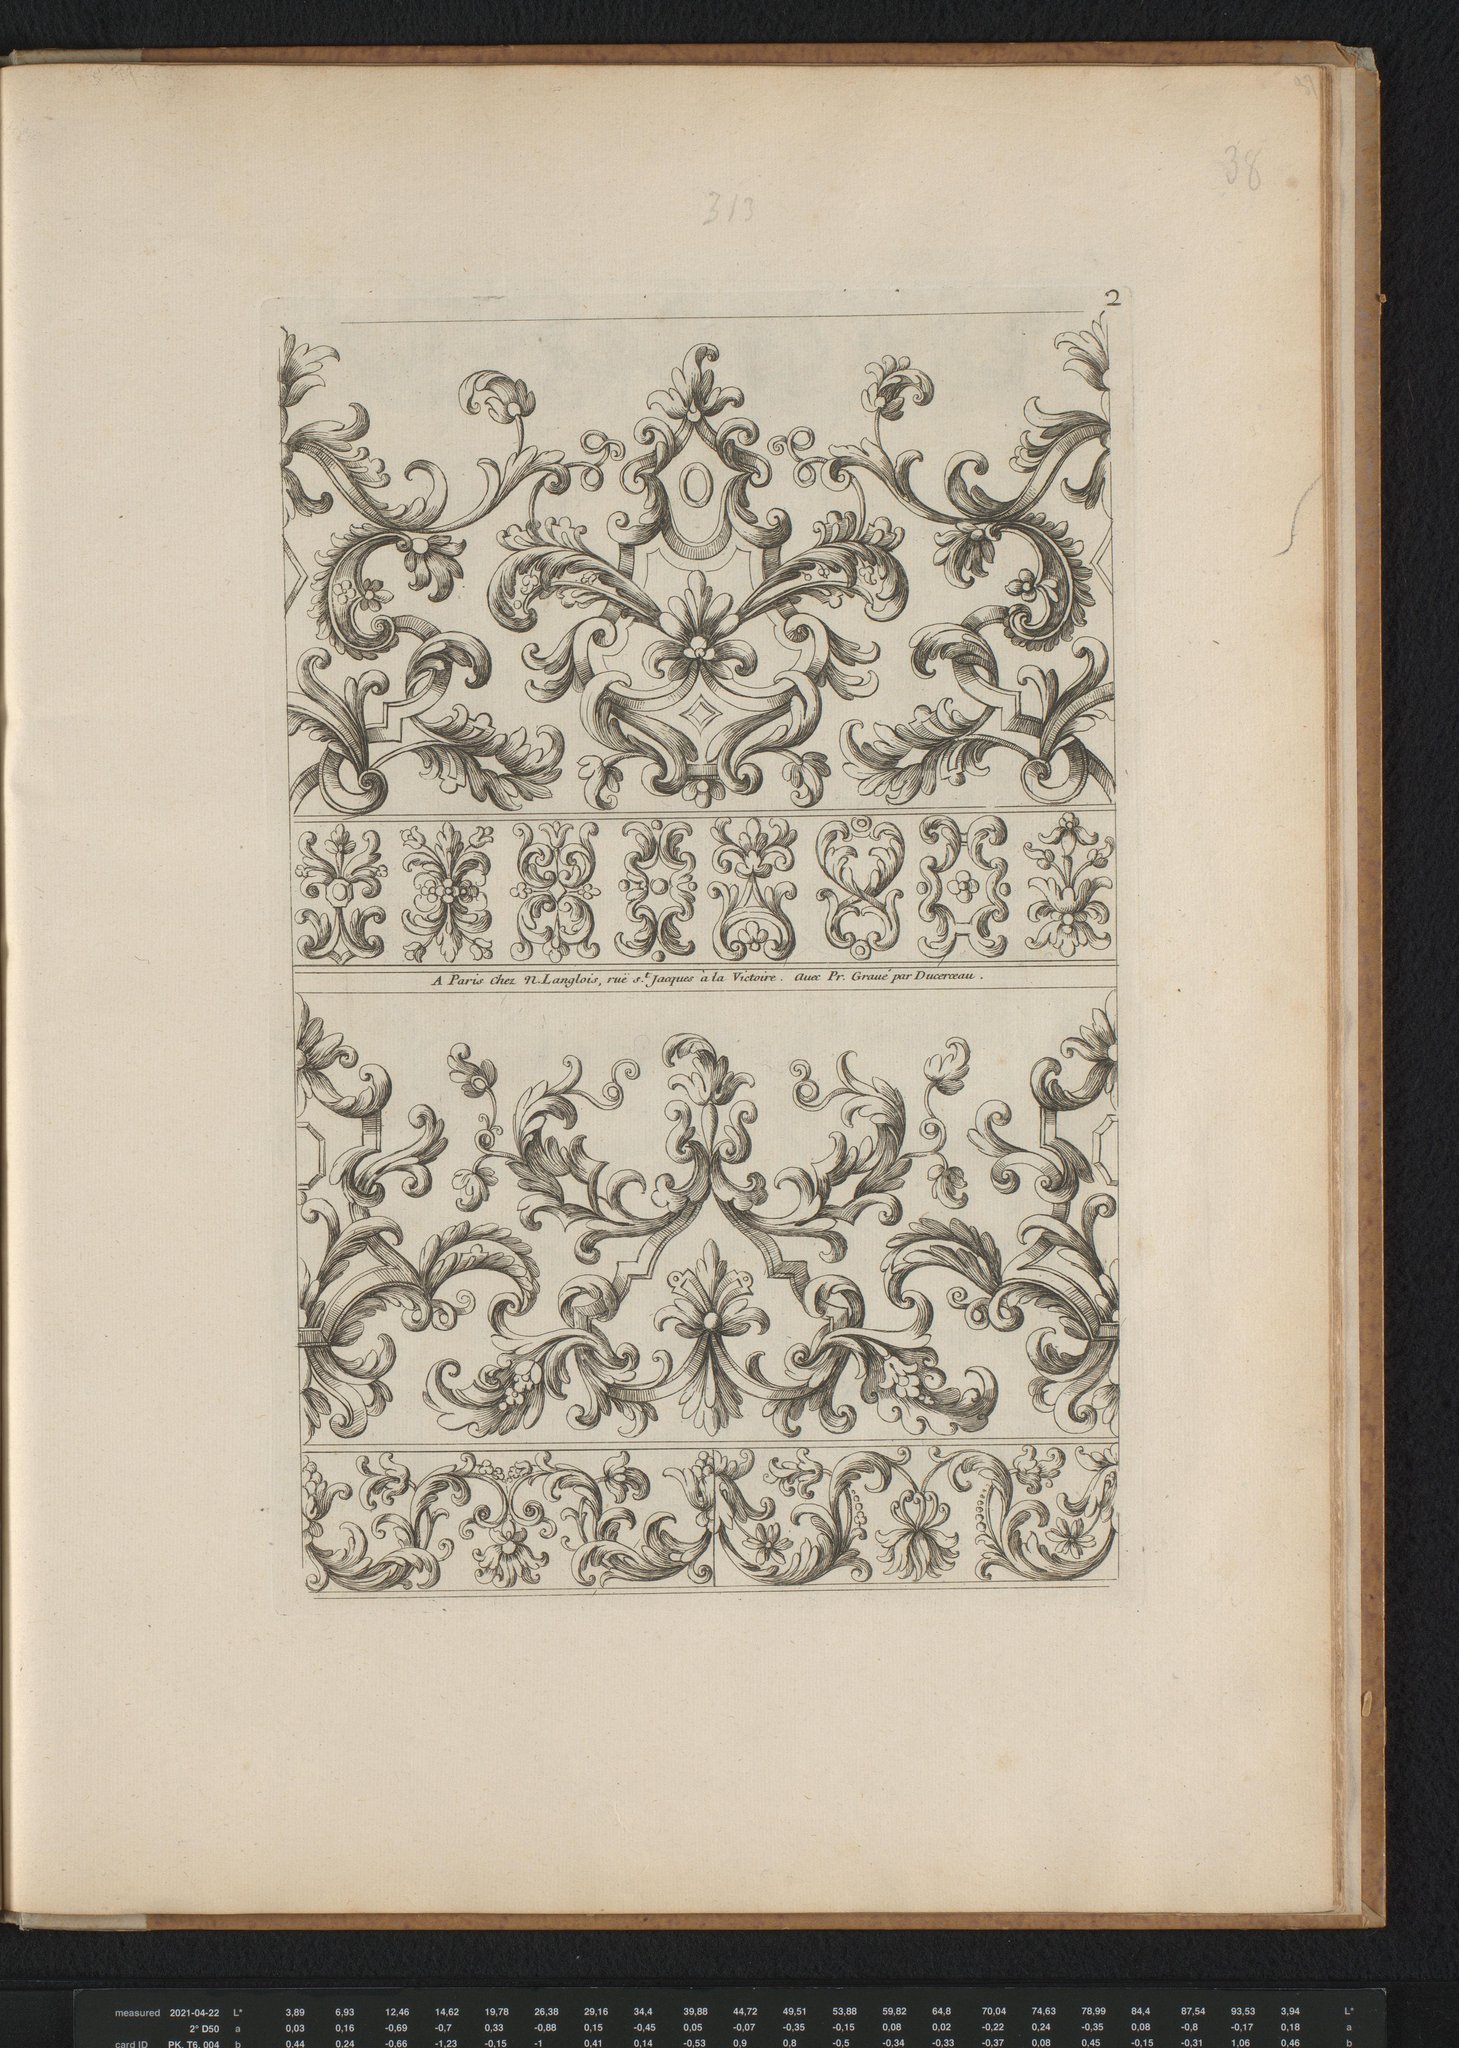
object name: album leaf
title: Morceaux de broderie pour manteaux et habits d'hommes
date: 1670-1690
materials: paper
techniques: etching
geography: paris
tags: foliage, tendrils, branches ~ ornament, embroidery (ornamentation)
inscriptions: collector's mark: Lugt 2760, collector's mark: Lugt 2228a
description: Deze prent maakt deel uit van een album.